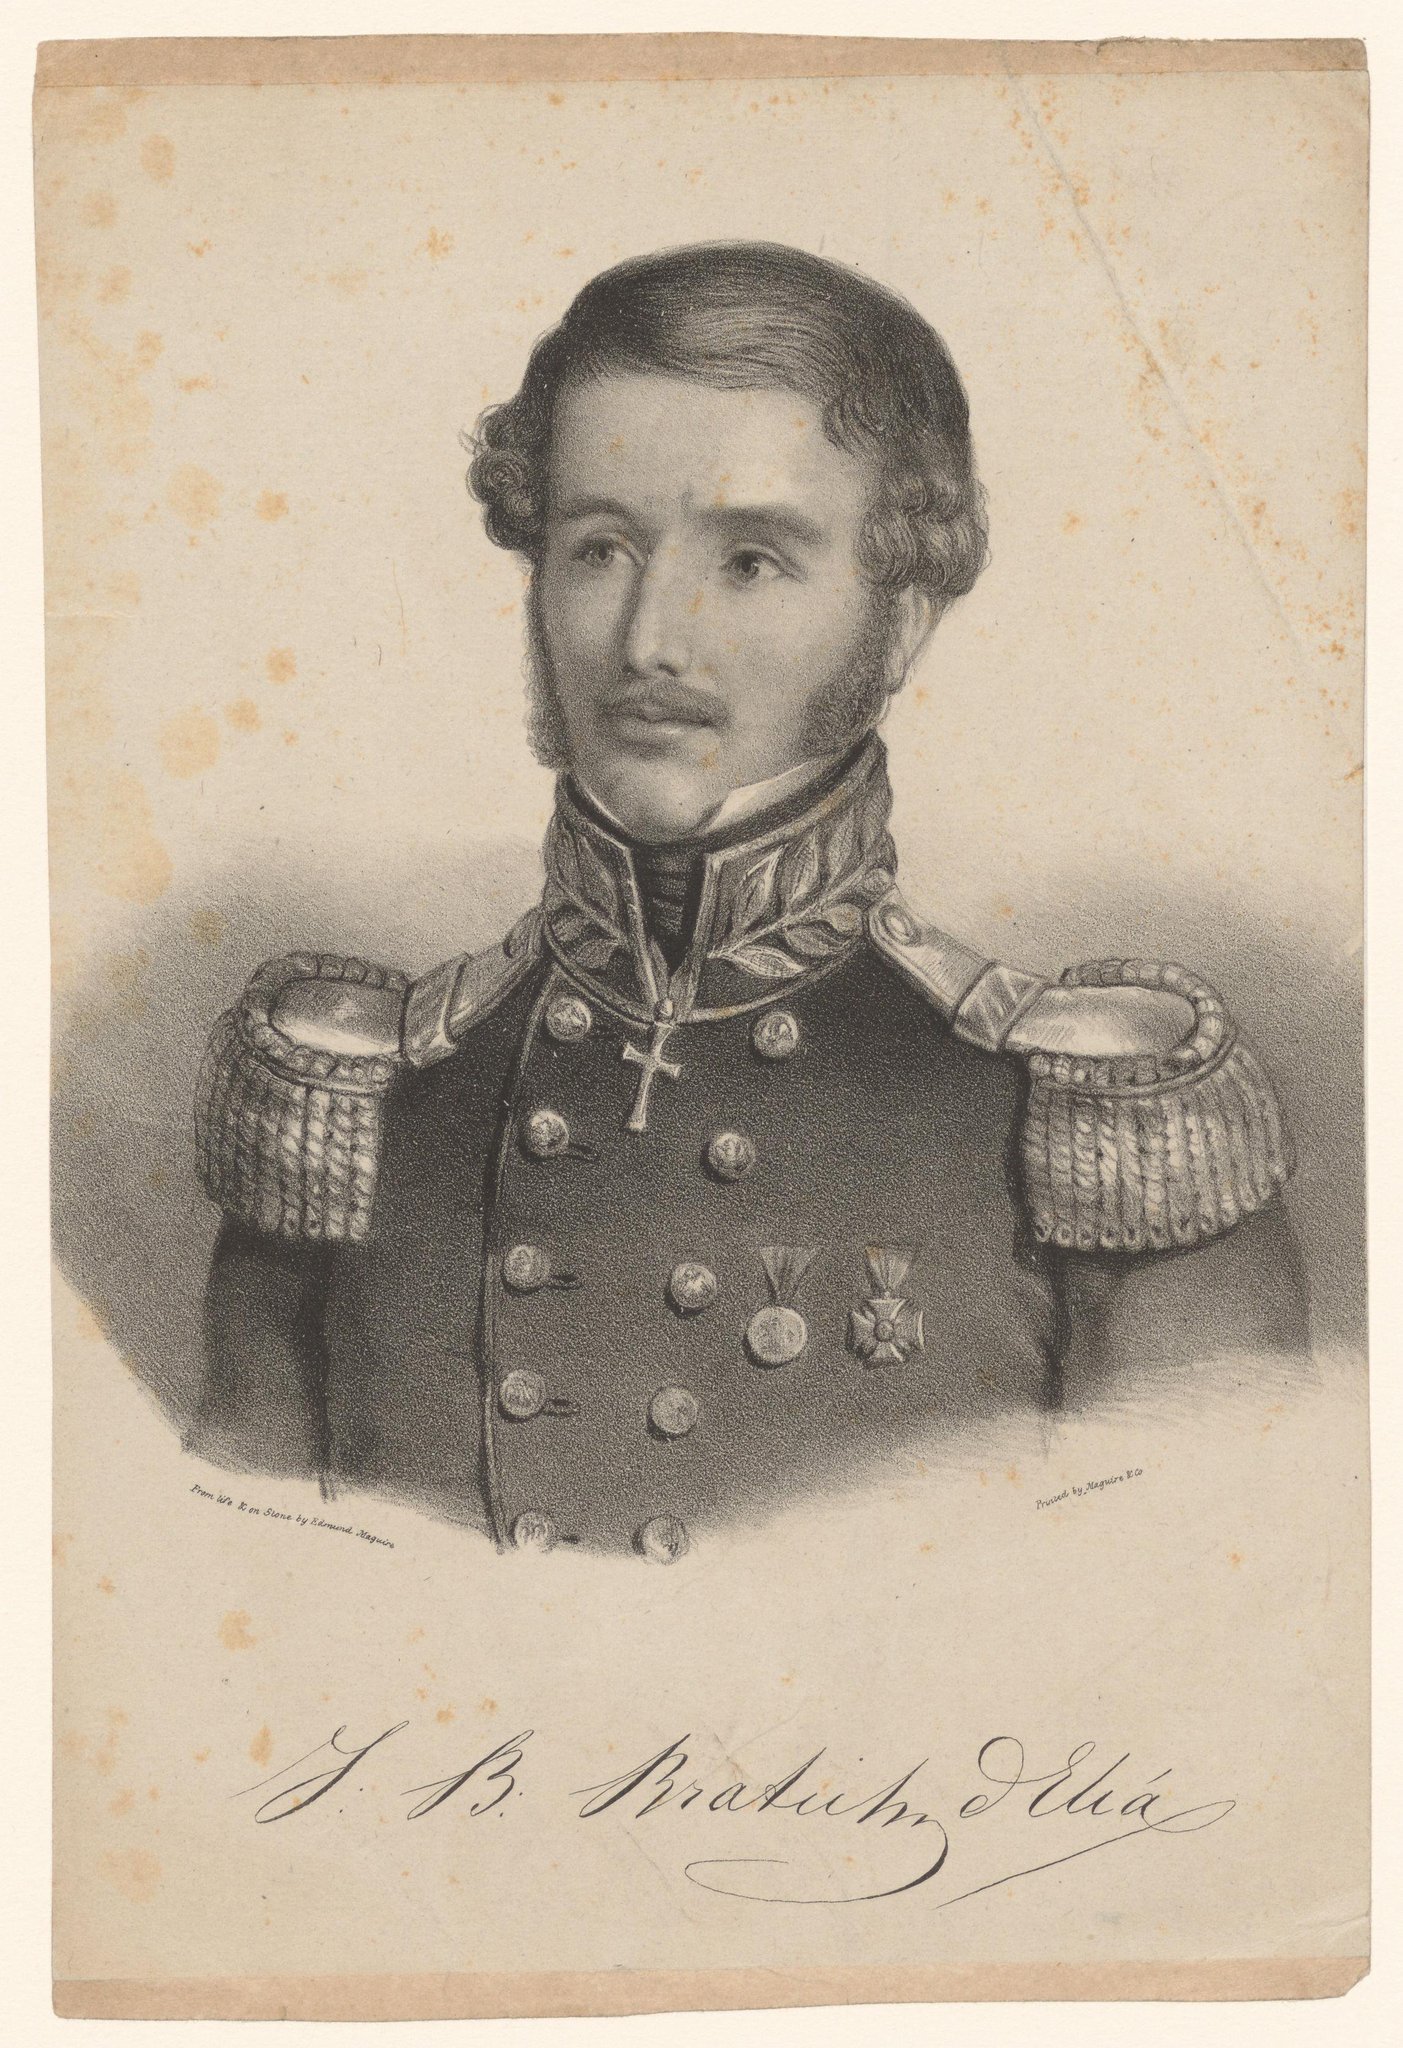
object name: print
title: Portret van een onbekende man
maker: edmund maguire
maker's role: print maker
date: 1800-1850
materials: paper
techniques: lithograph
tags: moustache, adult man, historical persons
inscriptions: collector's mark: Lugt 2228